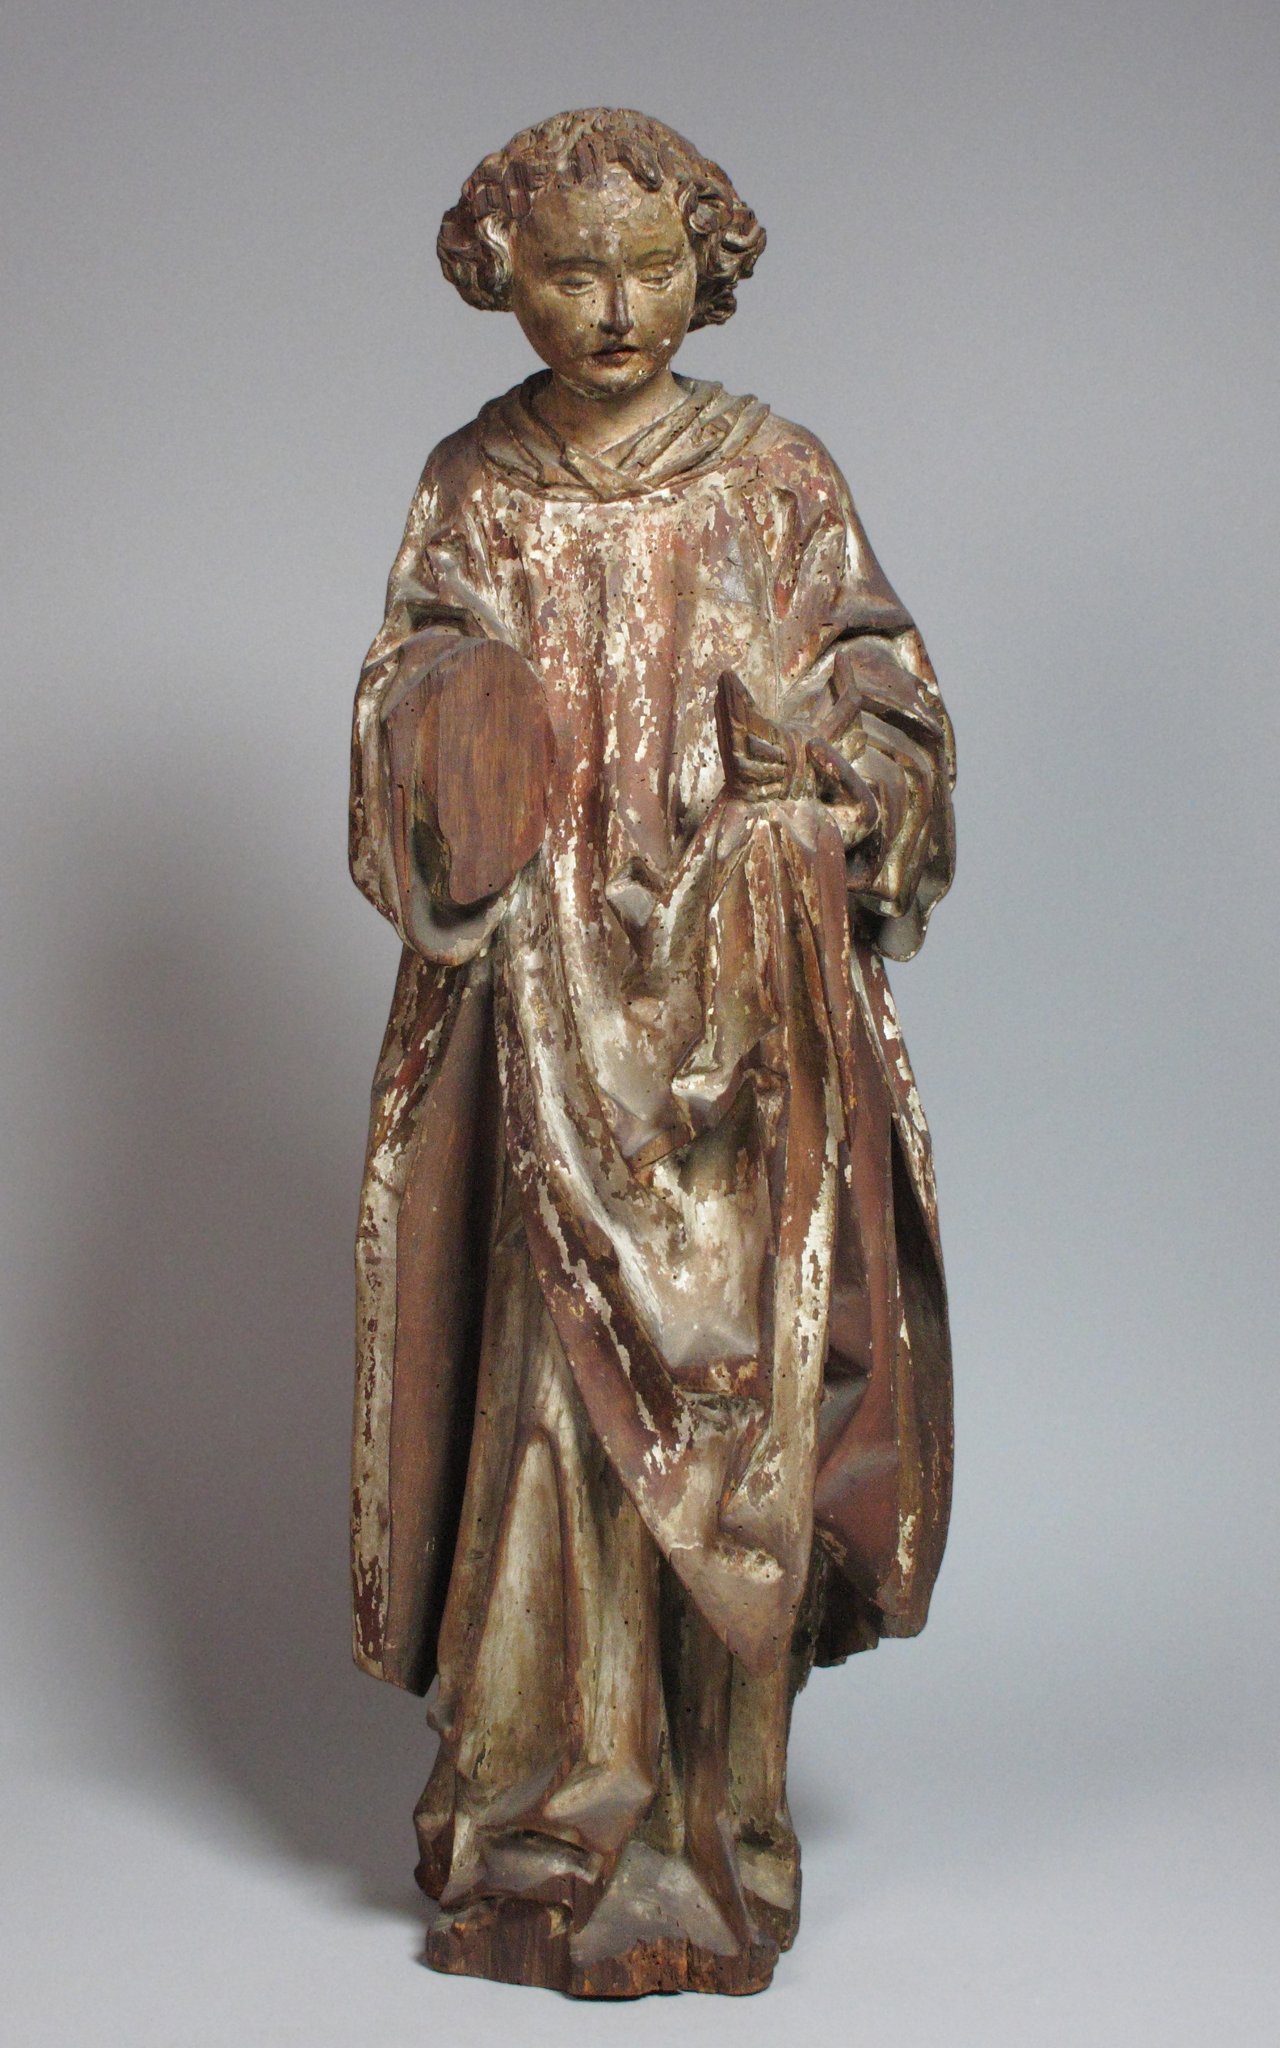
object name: statuette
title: Angel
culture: french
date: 1467-1500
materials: paint, wood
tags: angels